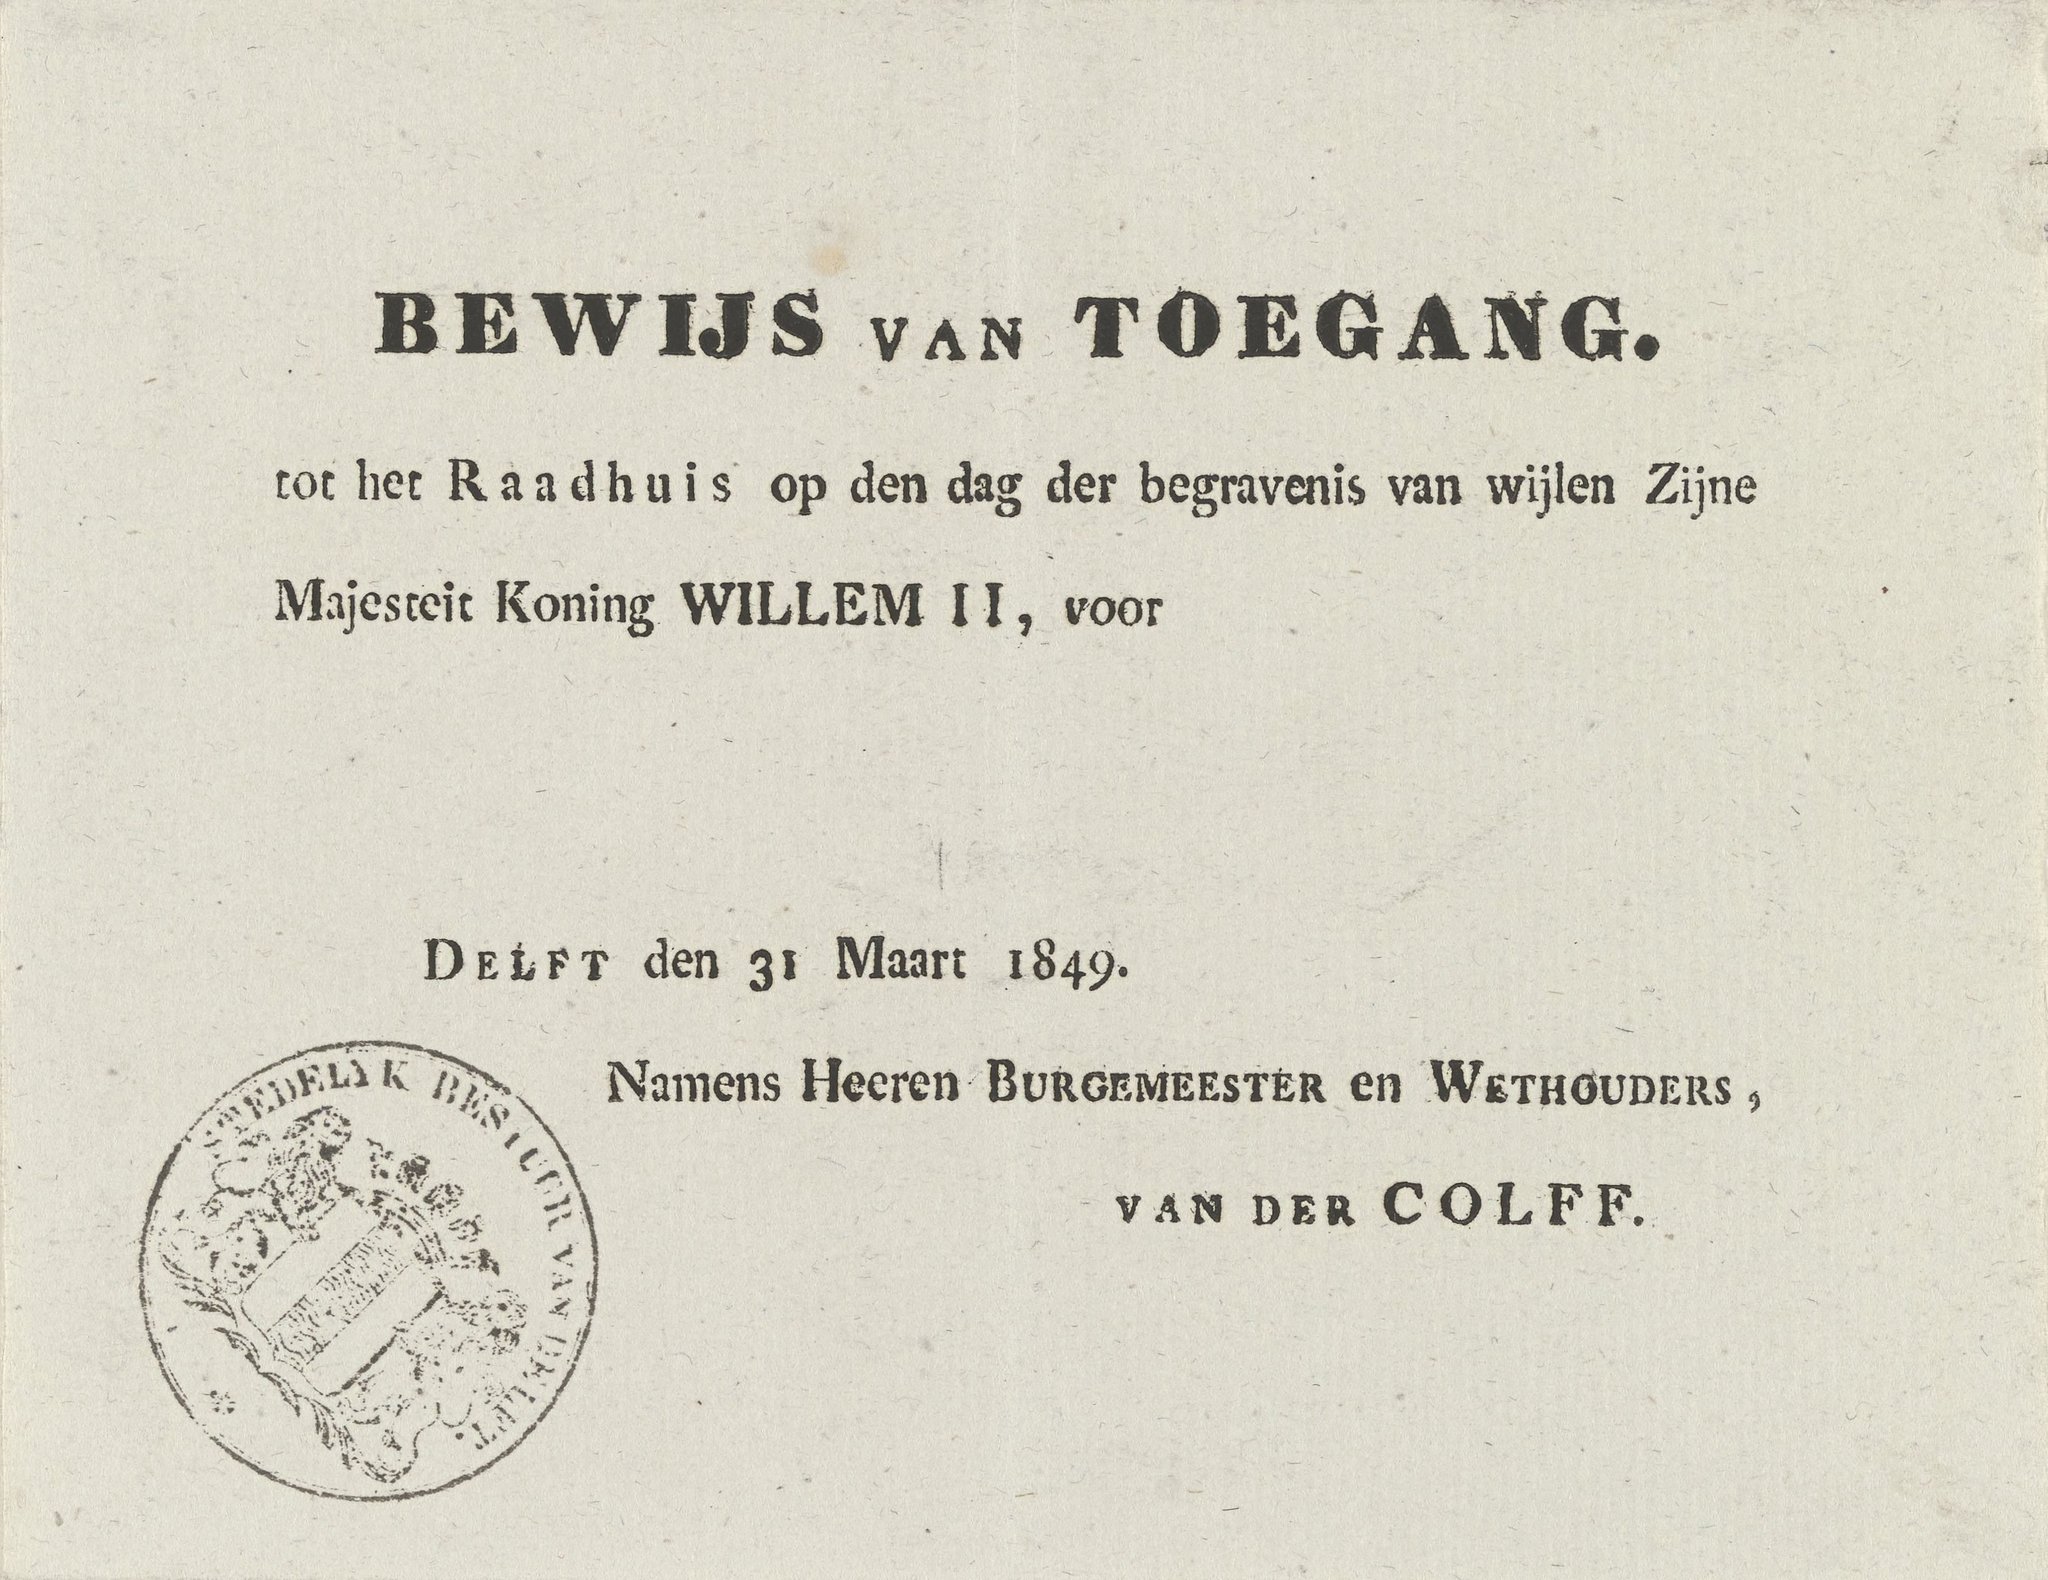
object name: admission ticket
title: Toegangsbewijs voor de begrafenis van koning Willem II, 1849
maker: Anonymous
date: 1849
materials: paper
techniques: letterpress printing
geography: netherlands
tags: the hague, william ii of the netherlands, funerary ceremonial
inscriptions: collector's mark: Lugt 2228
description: Toegangsbewijs tot het Raadhuis op de dag van de begrafenis van koning Willem II in de Nieuwe Kerk te Delft op 4 april 1849. Met stempel van het Stedelijk Bestuur van Delft.